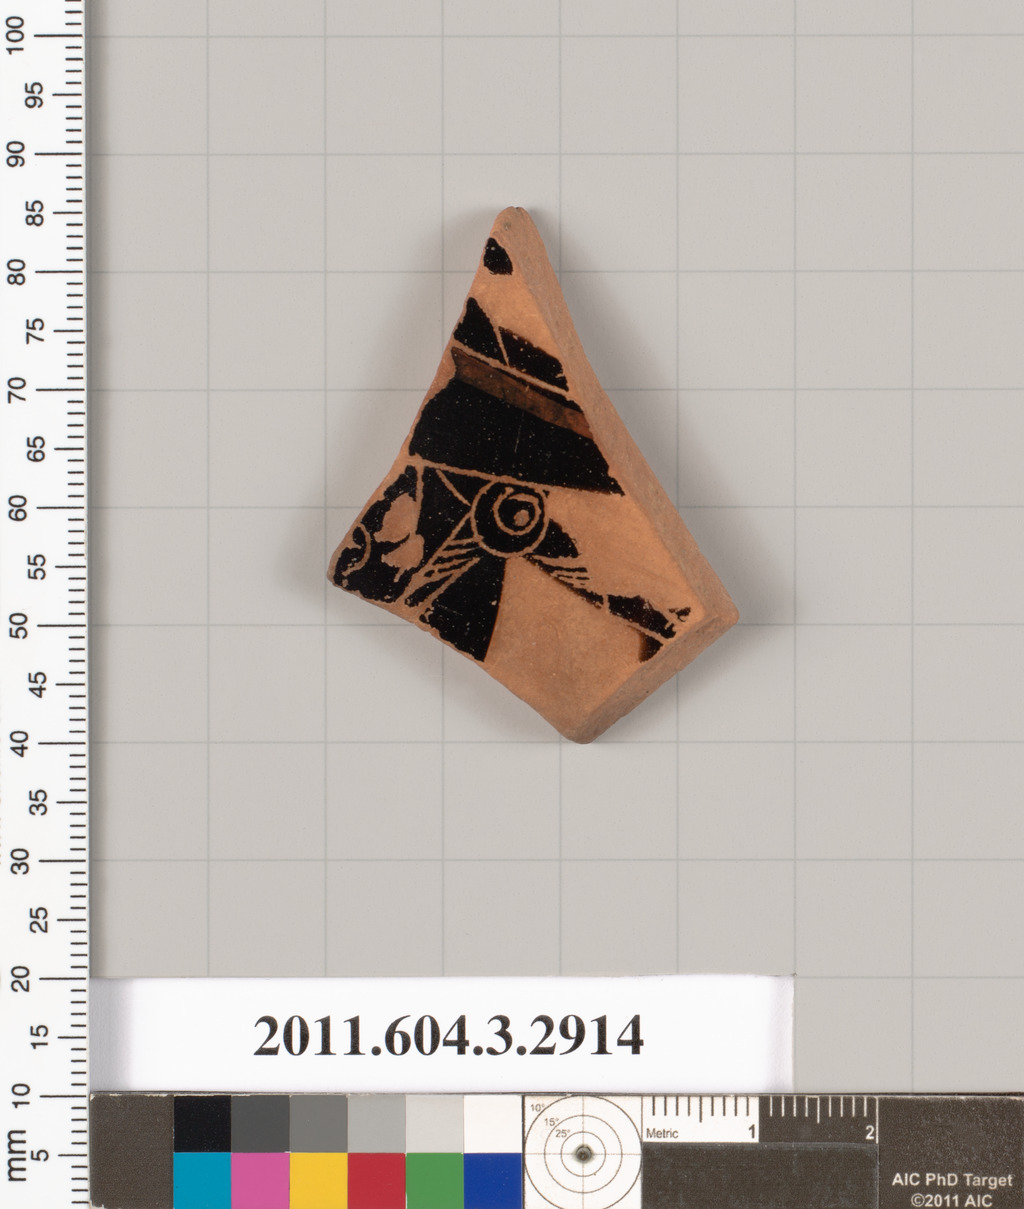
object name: neck amphora fragment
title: Terracotta fragment of a neck-amphora (jar)?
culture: greek, attic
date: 550-526 BCE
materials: terracotta